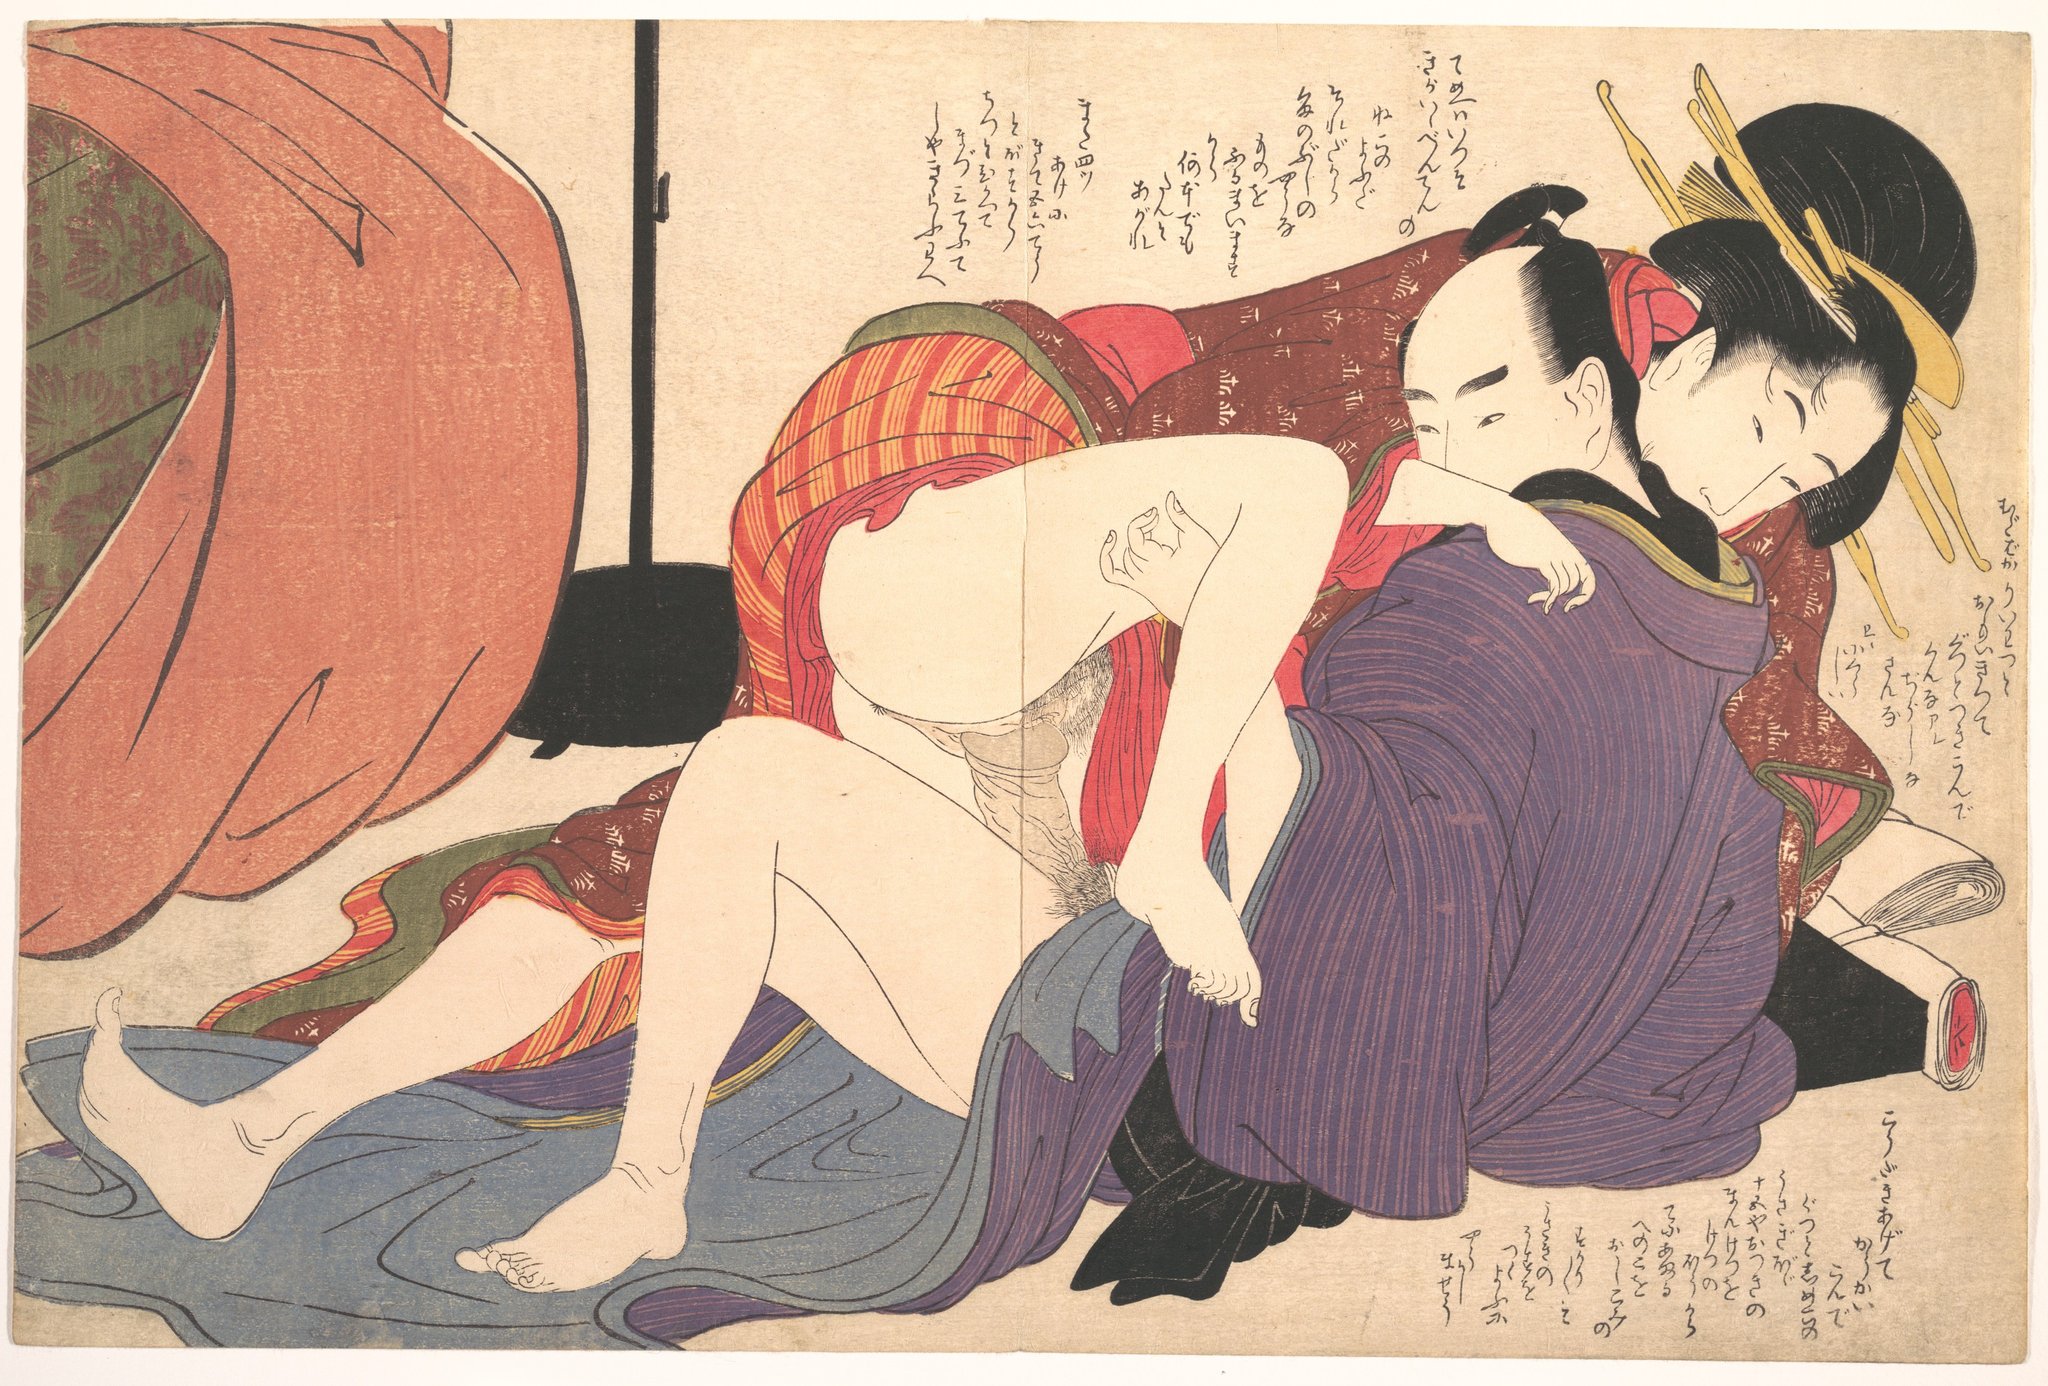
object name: print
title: Erotic Print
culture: japanese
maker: kitagawa utamaro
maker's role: artist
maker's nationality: japanese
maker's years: 1754-1806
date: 1753-1806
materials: ink, paper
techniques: woodblock print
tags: couples,men,lovers,women